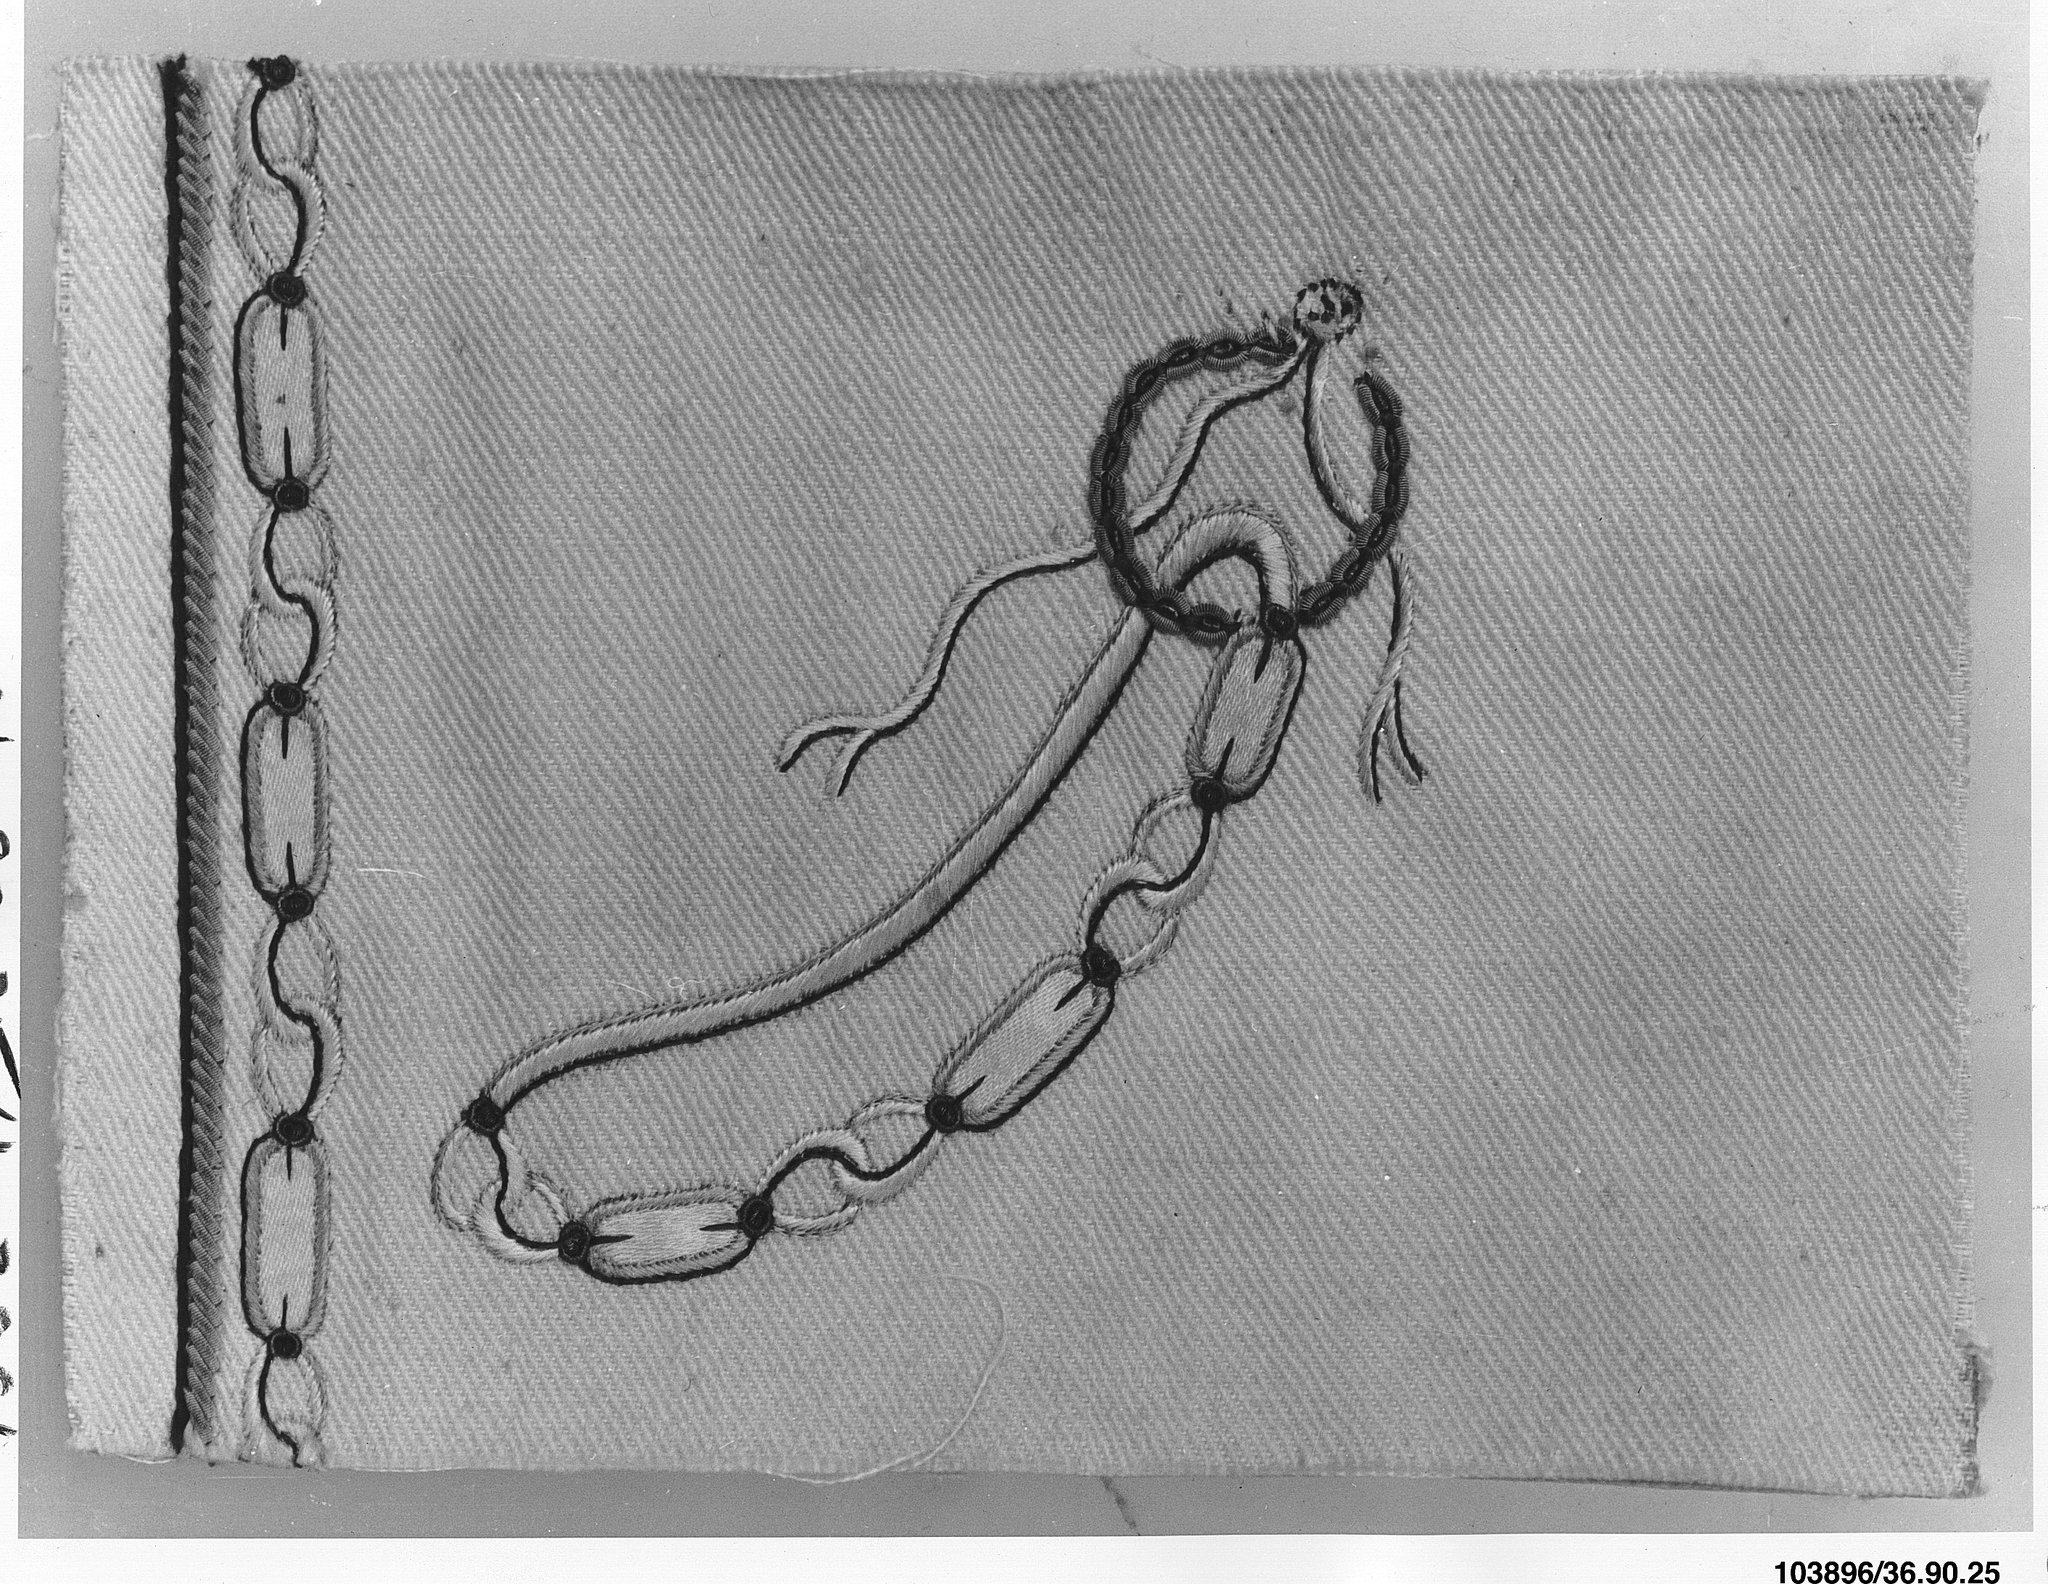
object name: sample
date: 1801-1833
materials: cotton, metal thread, silk